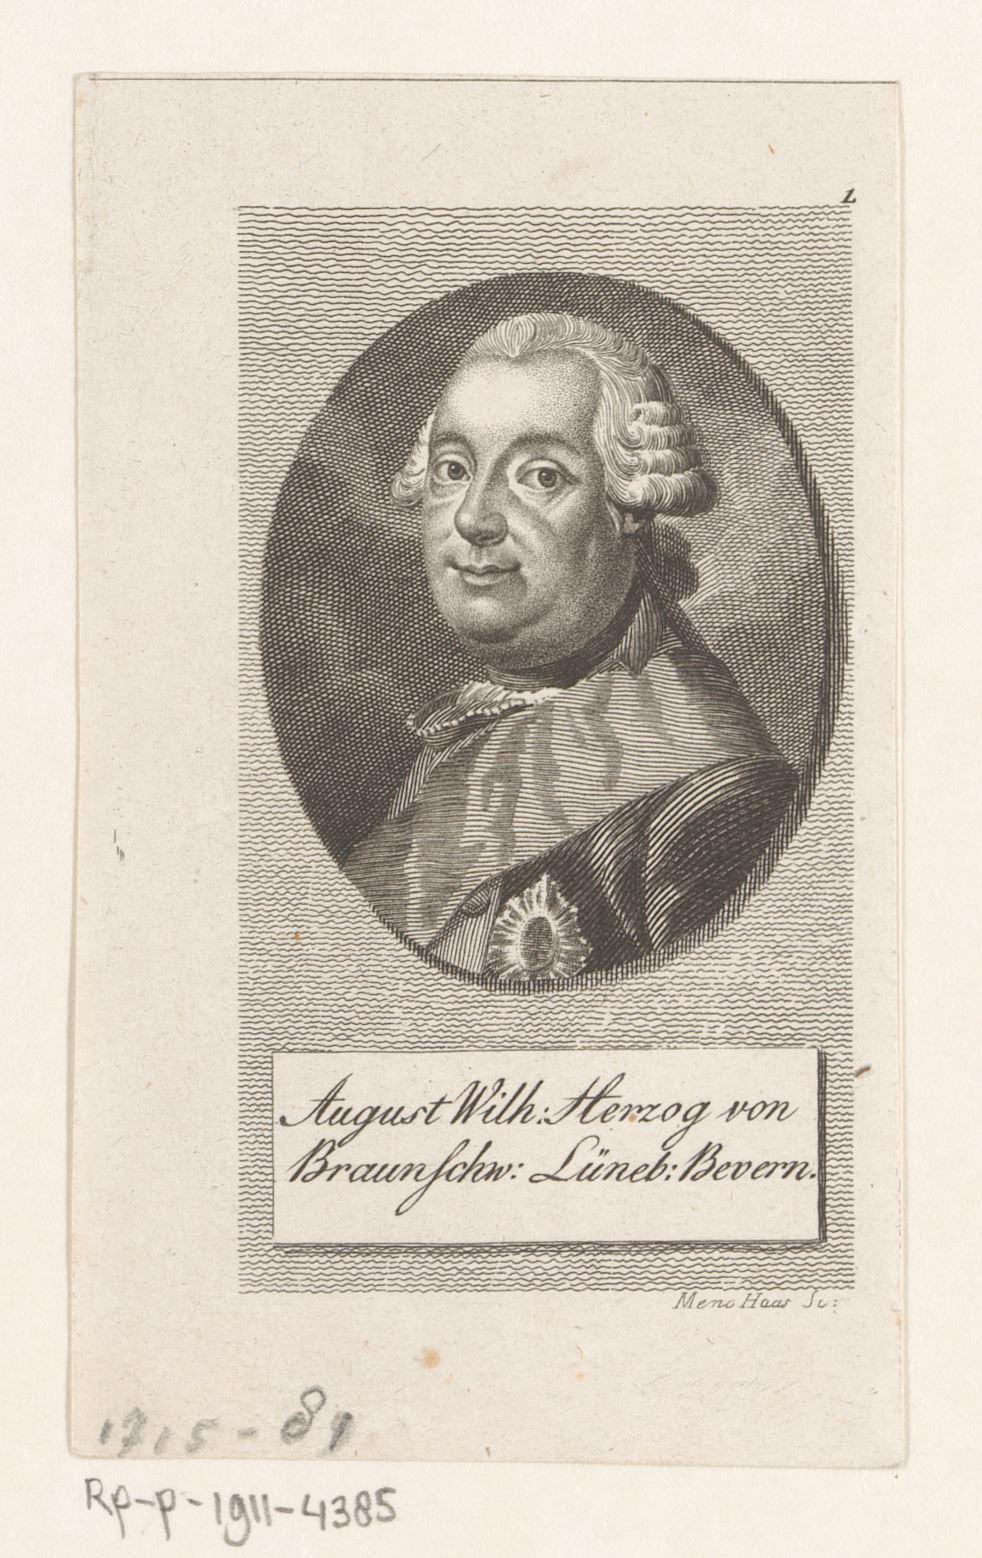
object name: print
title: Portret van August Wilhelm von Braunschweig-Lüneburg-Bevern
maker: meno haas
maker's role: print maker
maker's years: 1752-1833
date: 1762-1833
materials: paper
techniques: engraving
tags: knighthood order, commander-in-chief, general, marshal, historical persons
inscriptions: collector's mark: Lugt 2228